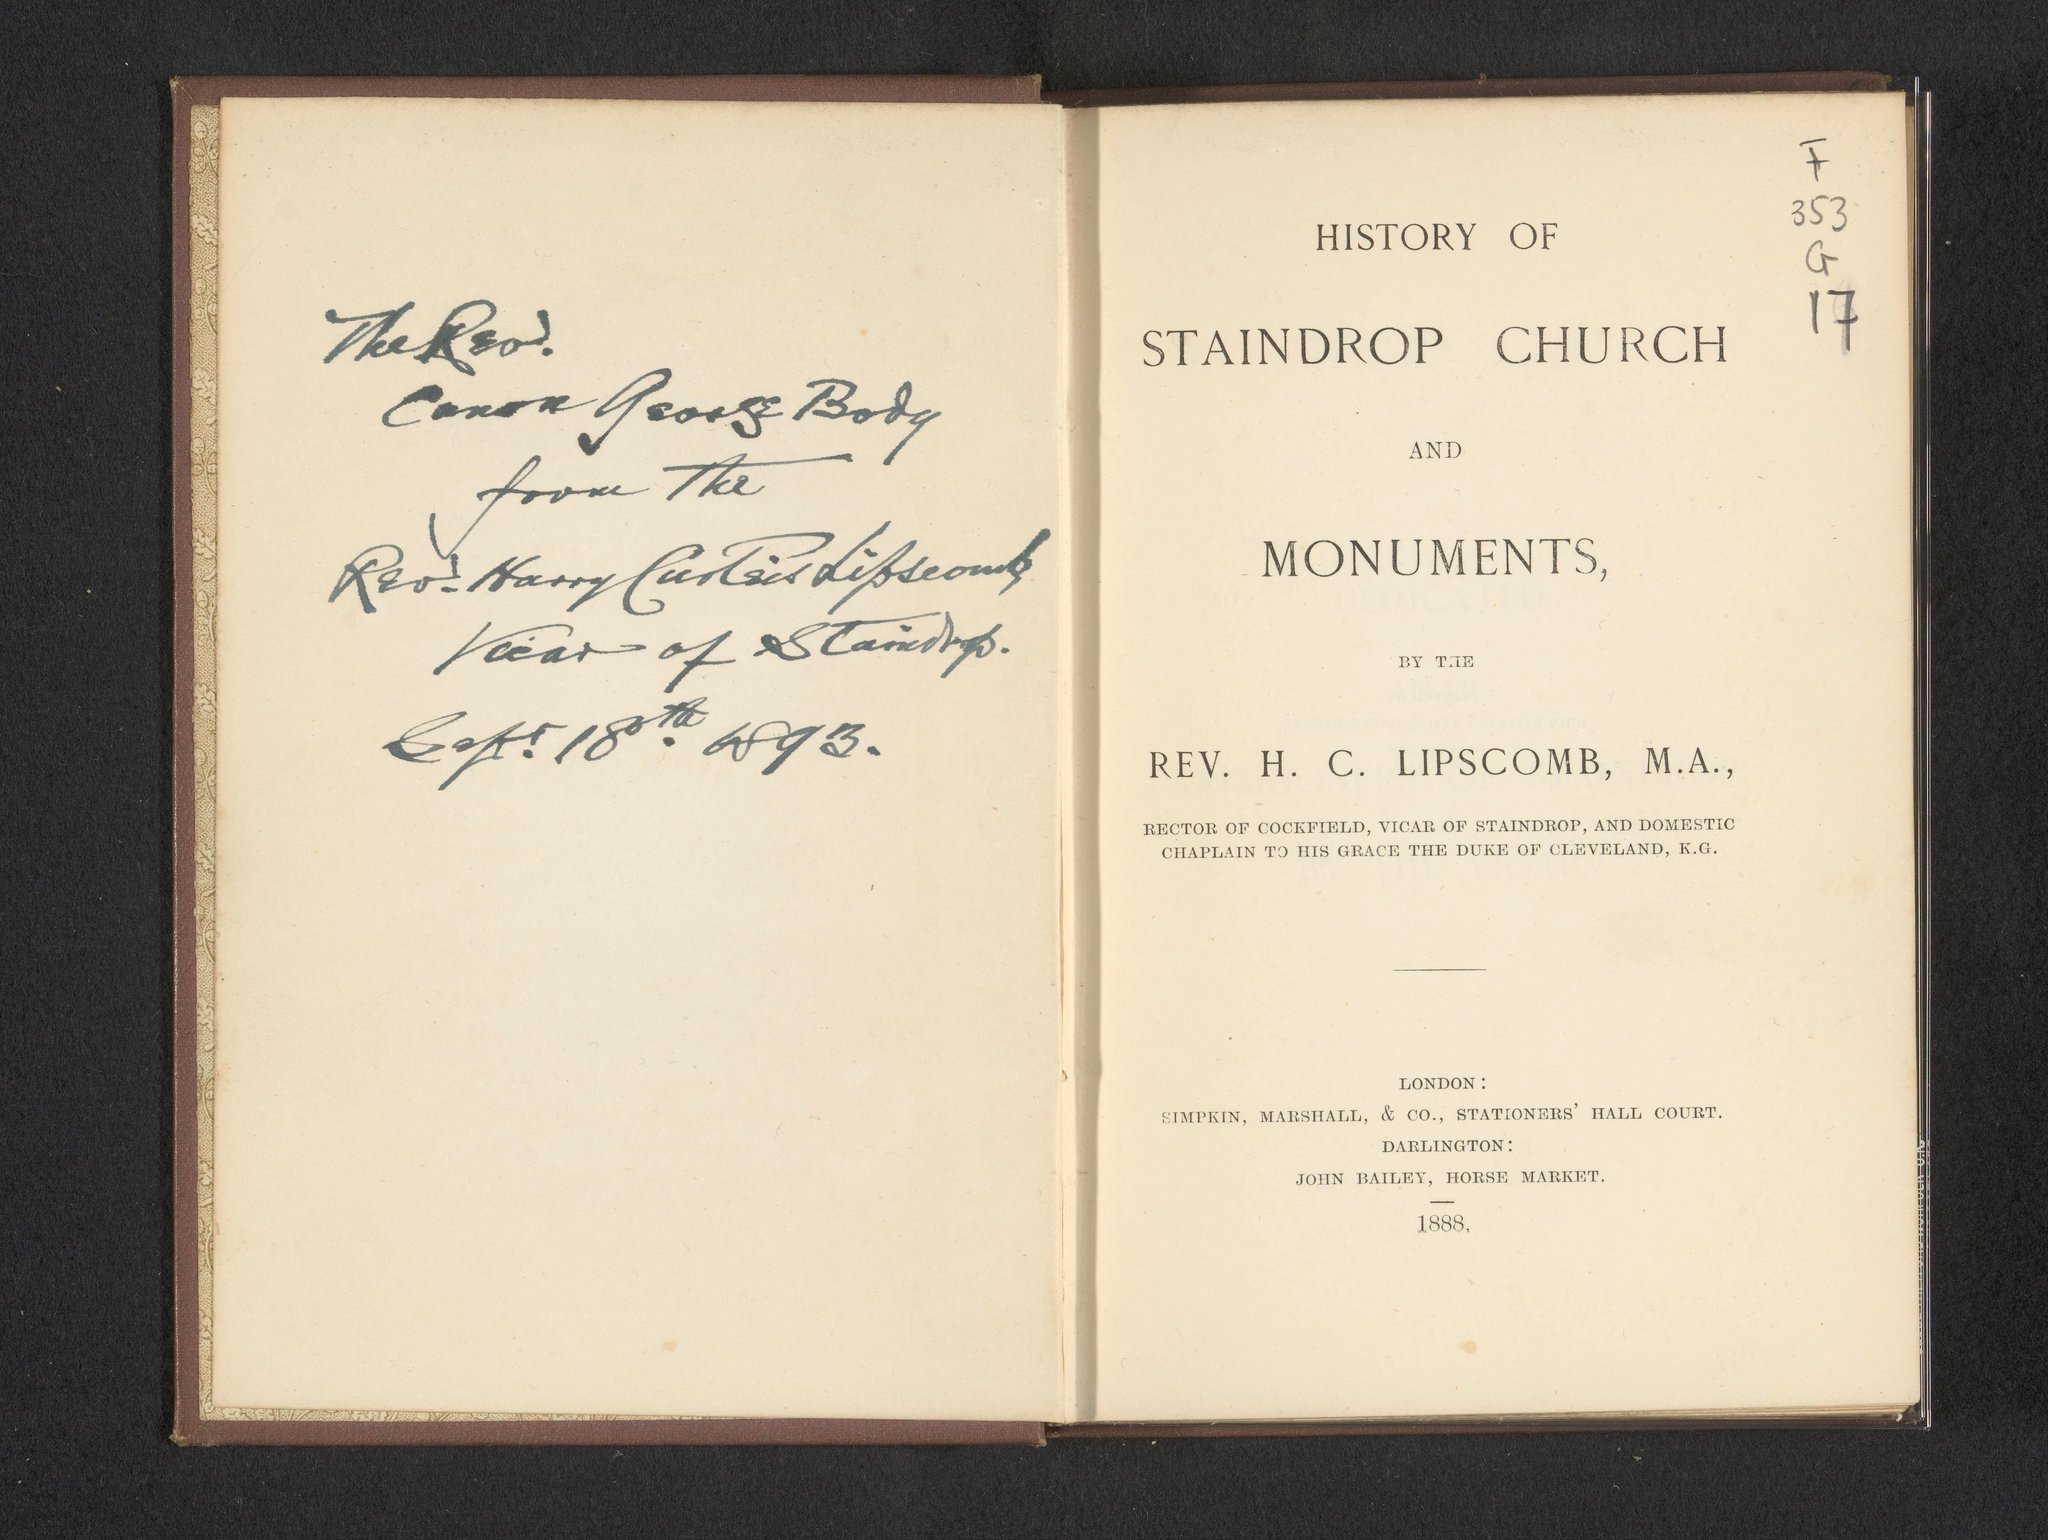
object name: book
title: History of Staindrop church and monuments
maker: h.c. lipscomb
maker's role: dominee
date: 1888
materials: cardboard, linen, paper, photographic support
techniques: albumen print, printing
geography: london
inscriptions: inscription: ‘Wes Wavenport March 1972 [...]’, name: ‘Matthew Mackey Newcastle’, inscription: ‘The Rev. Canon George Body from the Rev. Harry Curteis Lipscomb Vicar of Staindrop Sept 18th. 1893.’